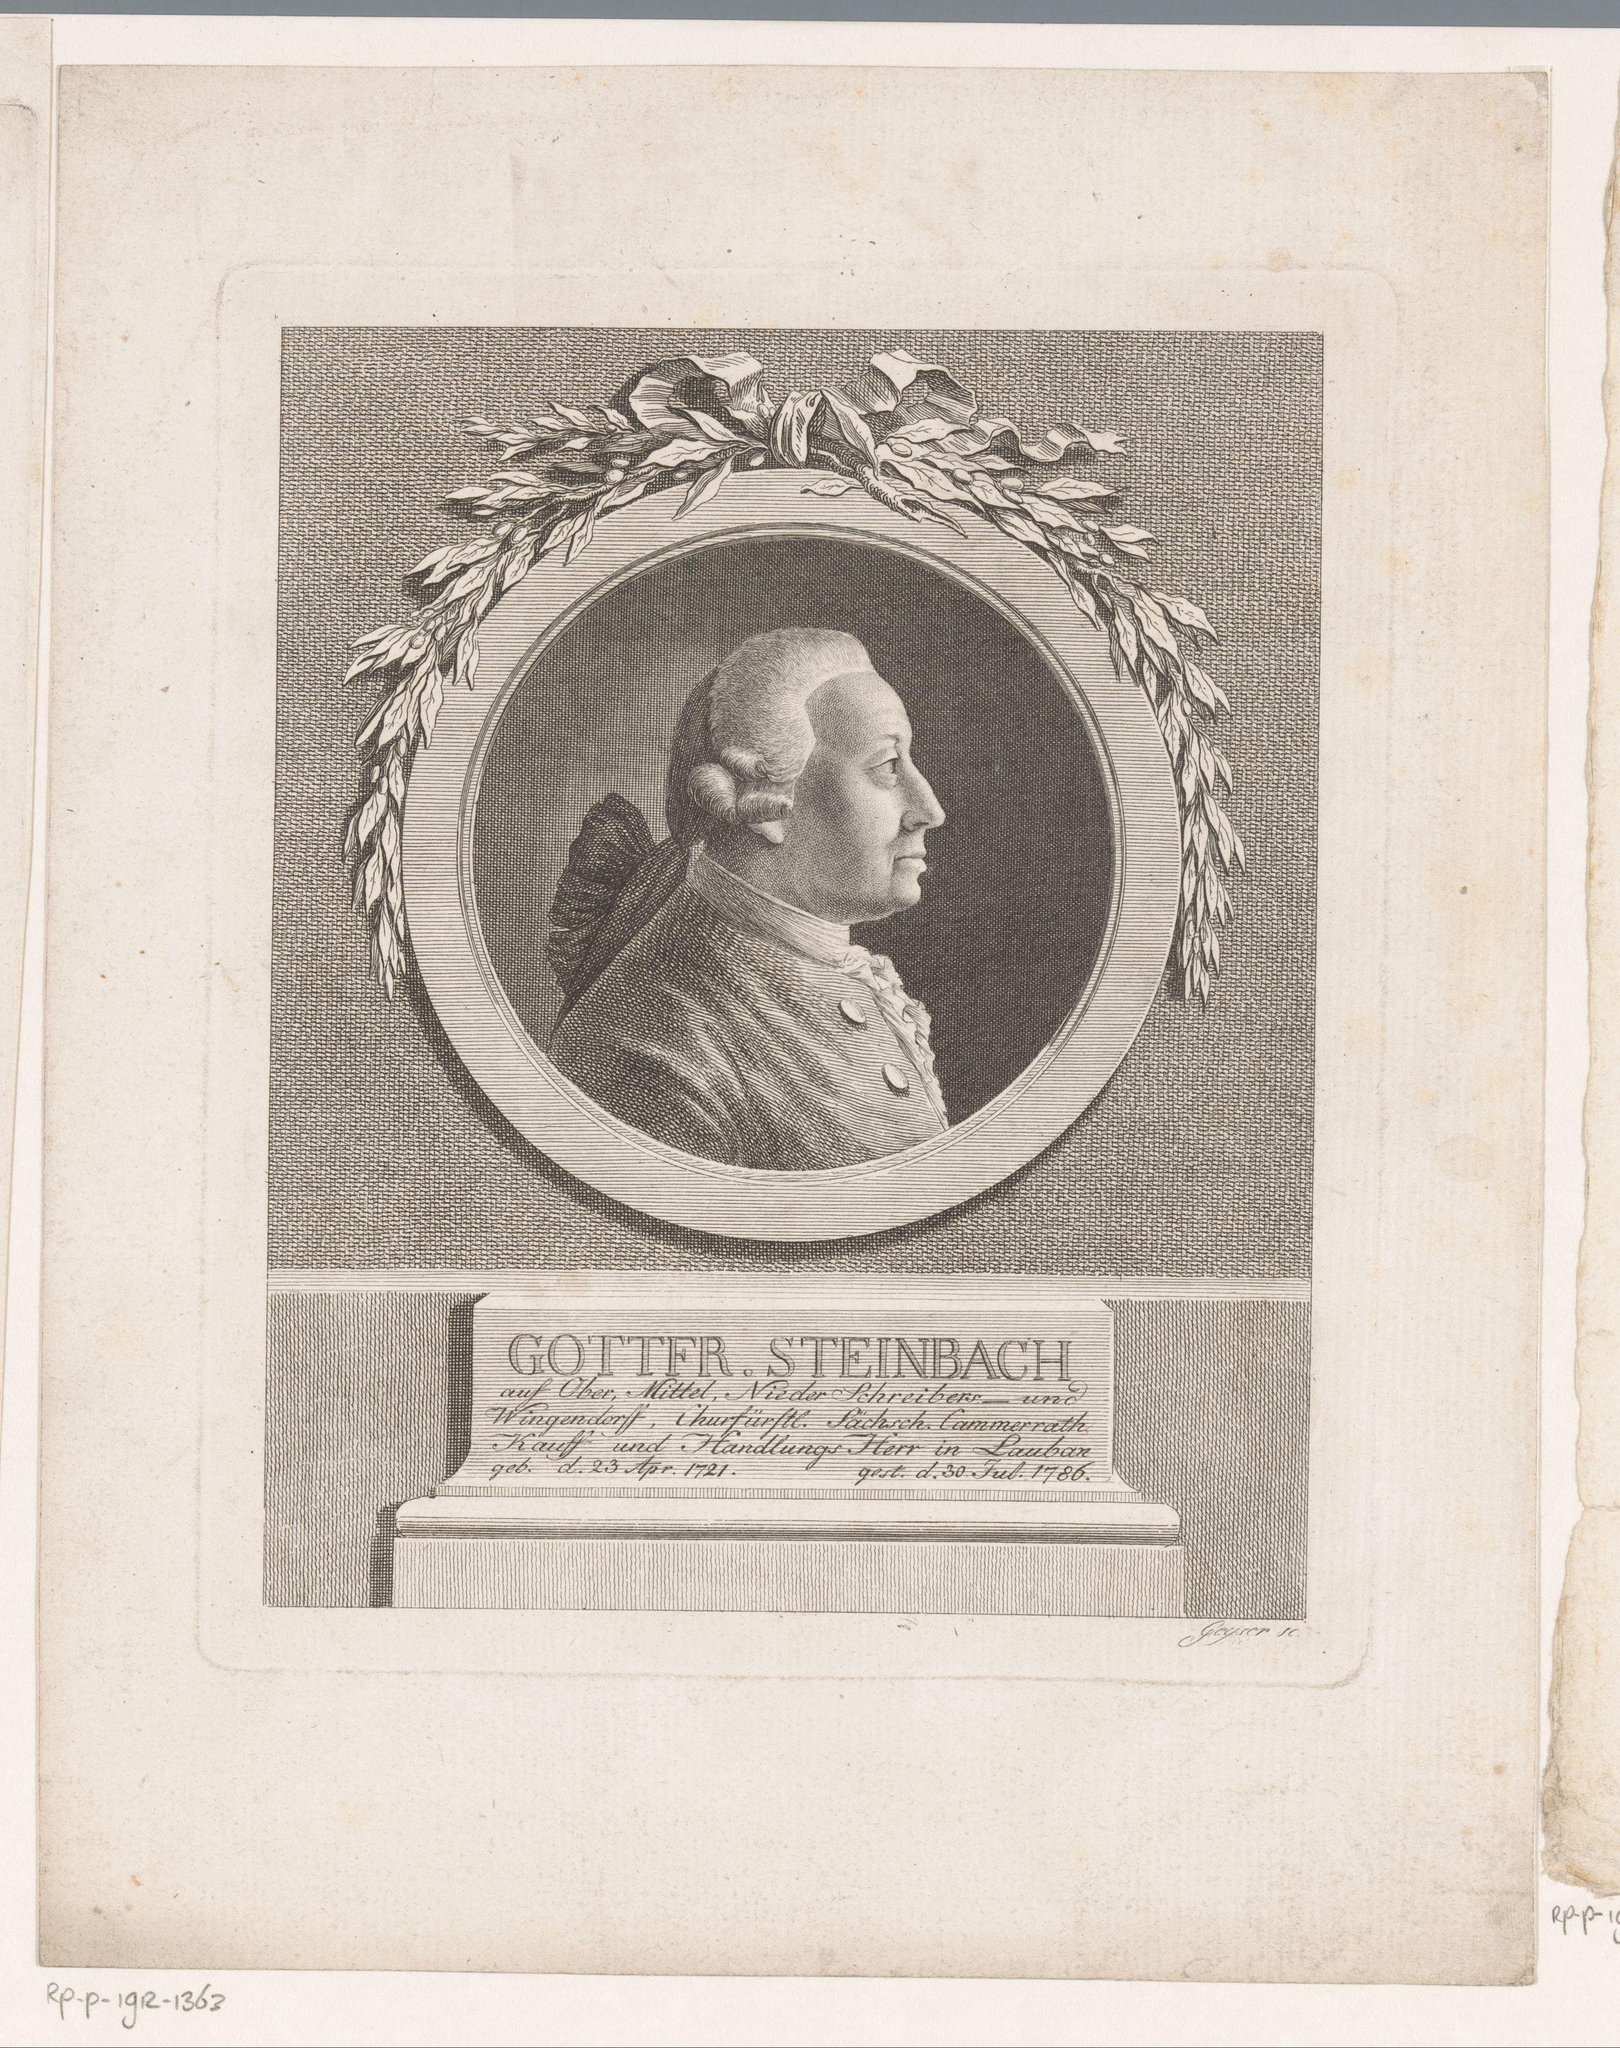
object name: print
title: Portret van Gottfried Steinbach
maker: christian gottlieb geyser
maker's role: print maker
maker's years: 1742-1803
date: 1787-1803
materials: paper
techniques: engraving, etching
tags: historical persons, merchant, salesman, trees: olive-tree (+ branch, stick)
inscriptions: collector's mark: Lugt 2228